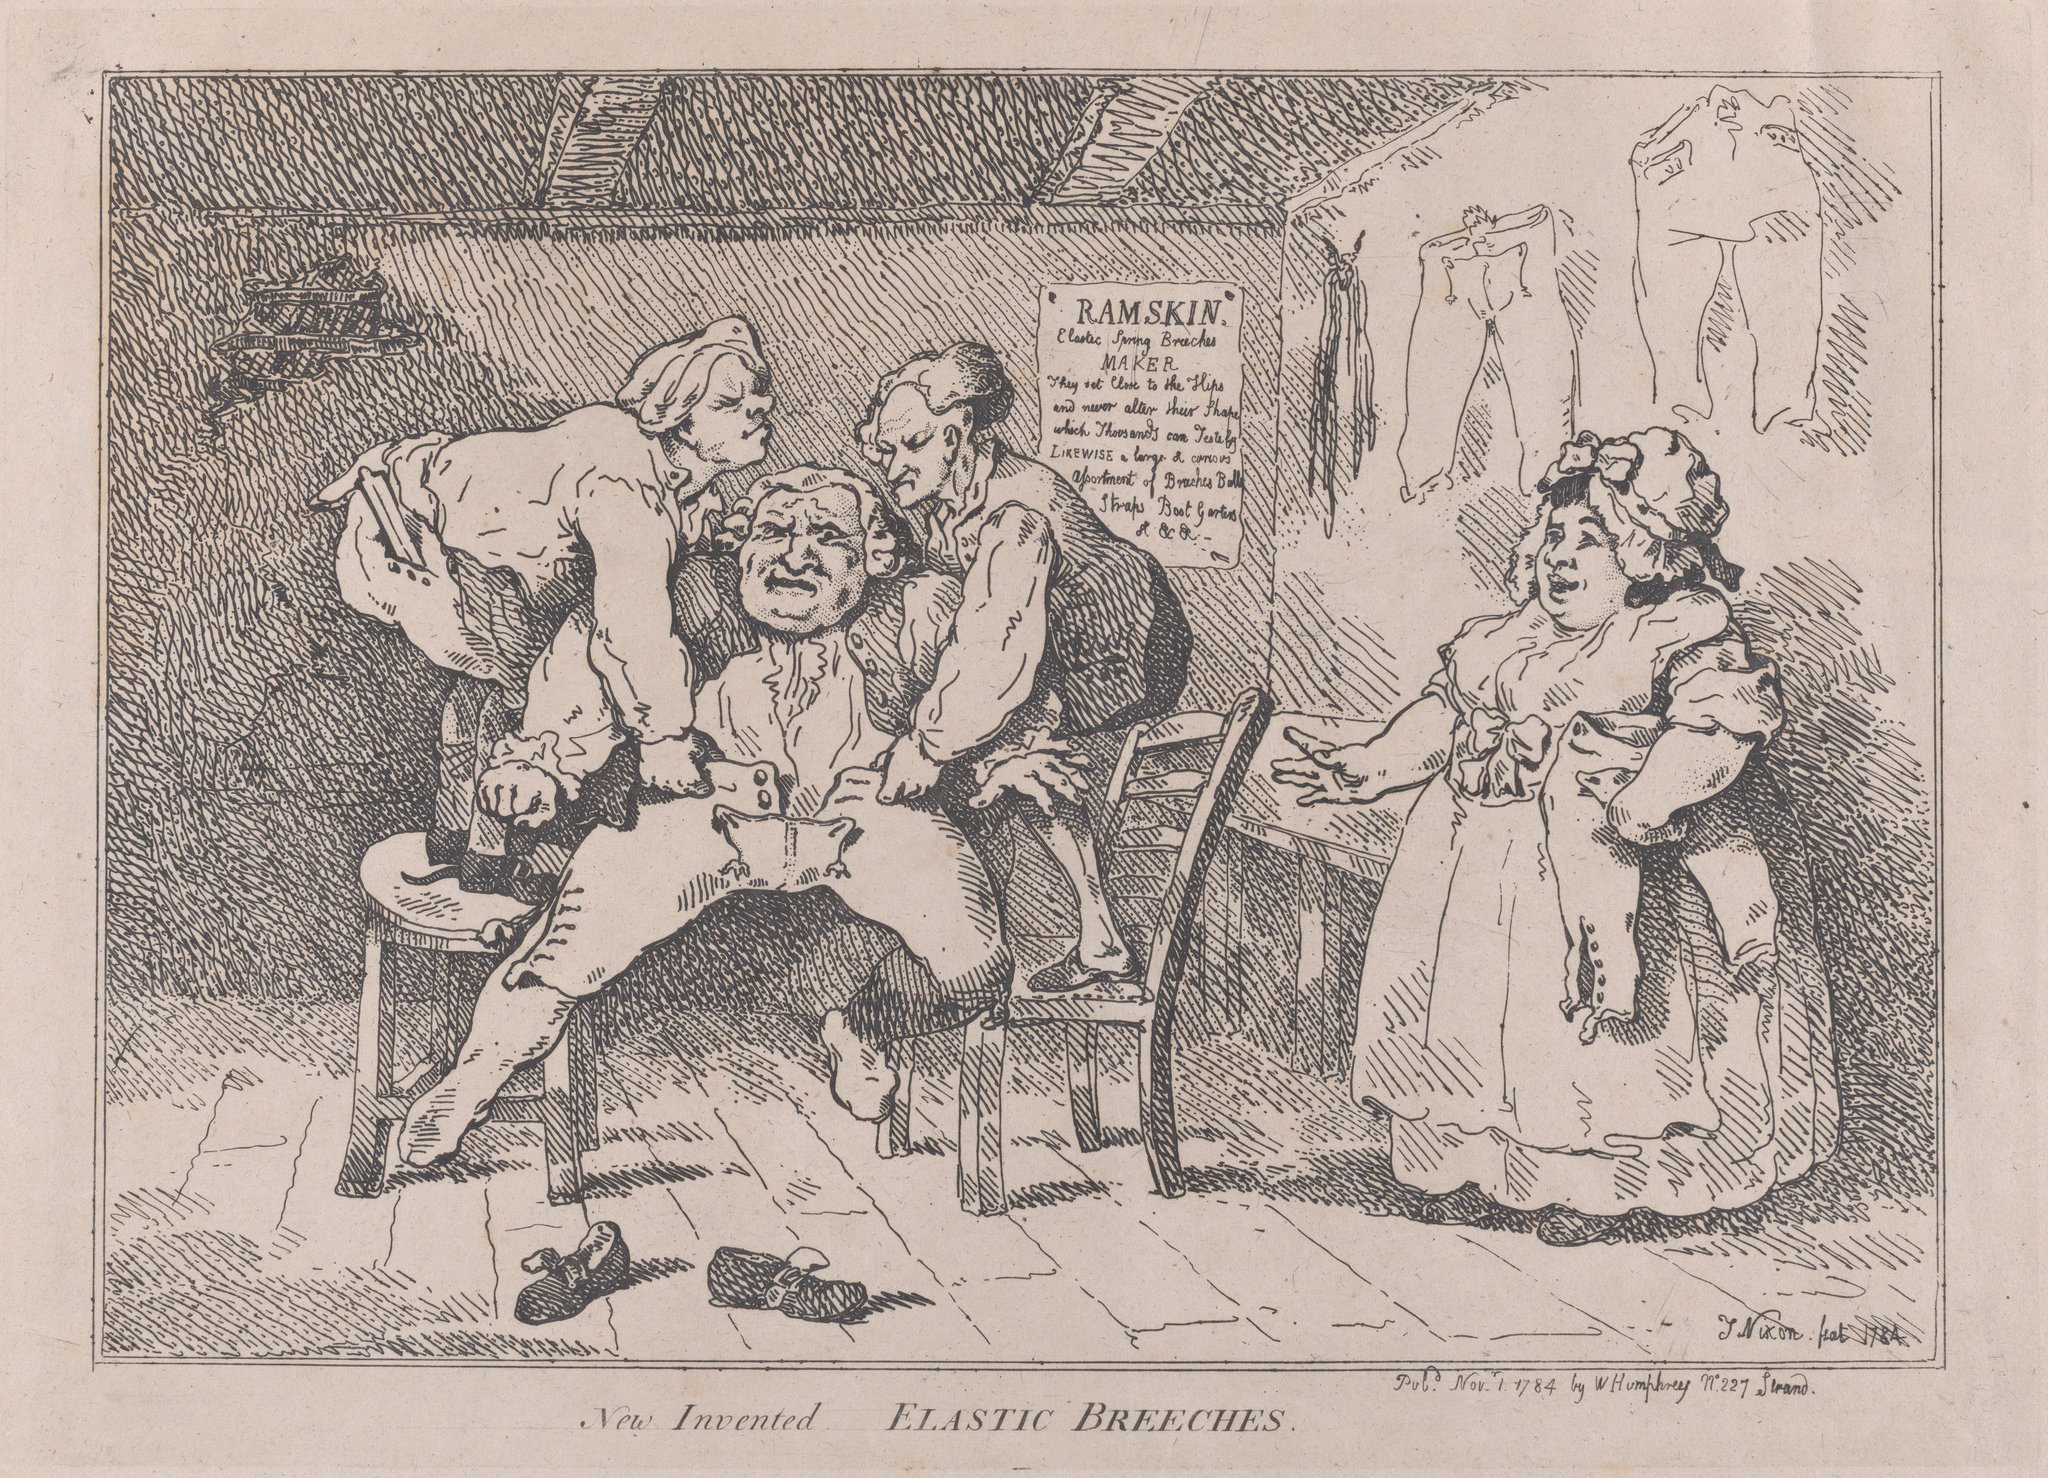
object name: print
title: New Invented Elastic Breeches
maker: thomas rowlandson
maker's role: artist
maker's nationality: british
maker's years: 1757-1827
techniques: etching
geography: london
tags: satire,men,women,dressing